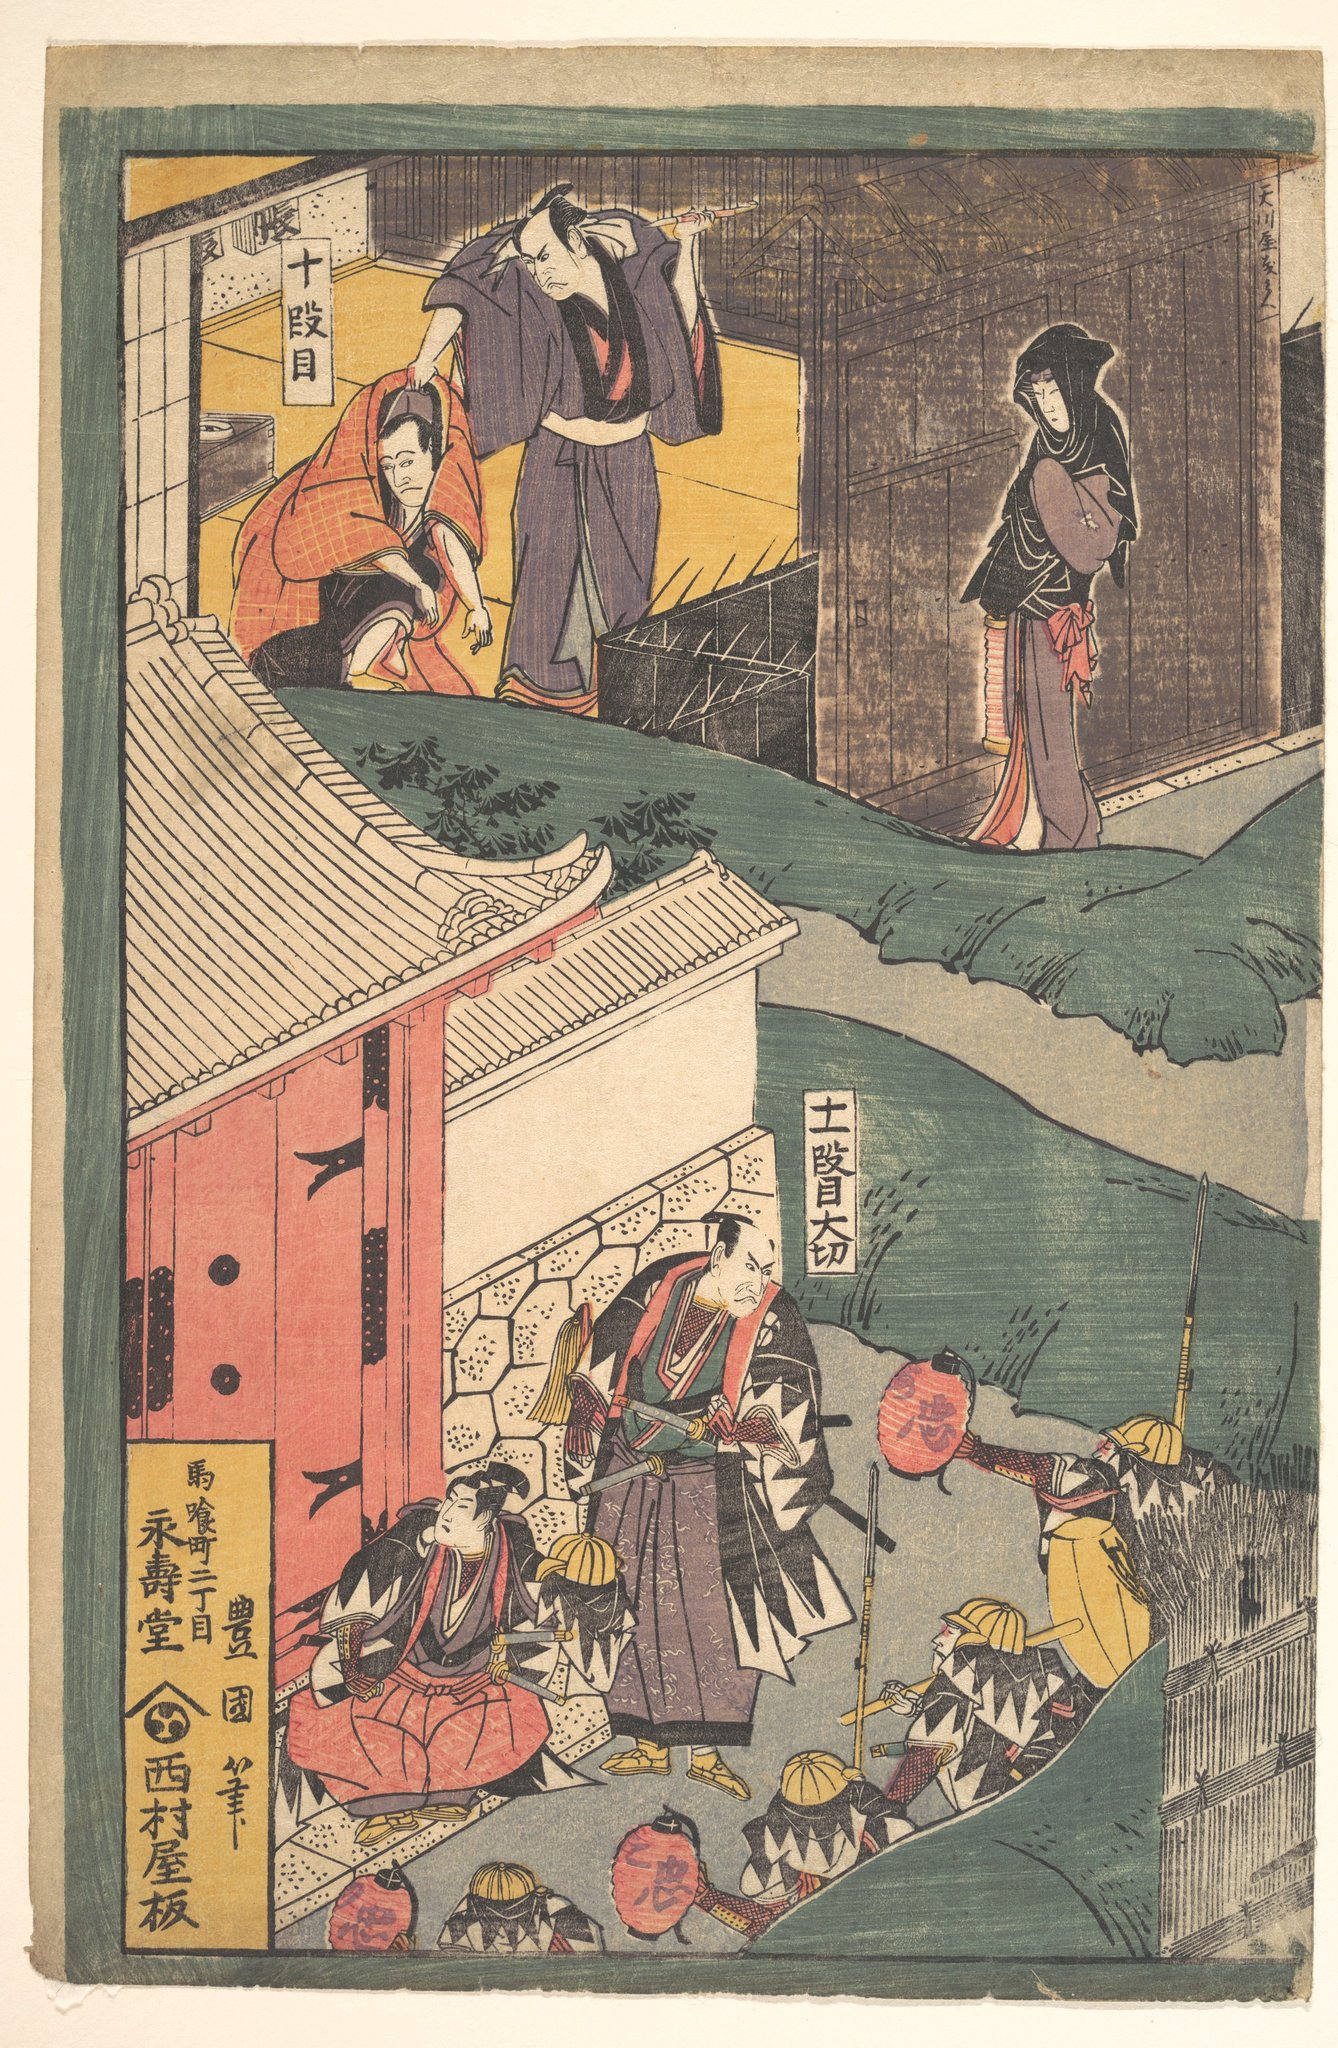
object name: print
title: The Loyal League (Chushingura)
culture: japanese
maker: utagawa toyokuni ii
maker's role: artist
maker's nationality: japanese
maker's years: 1777-1835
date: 1615-1868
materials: ink, paper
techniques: woodblock print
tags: houses,men